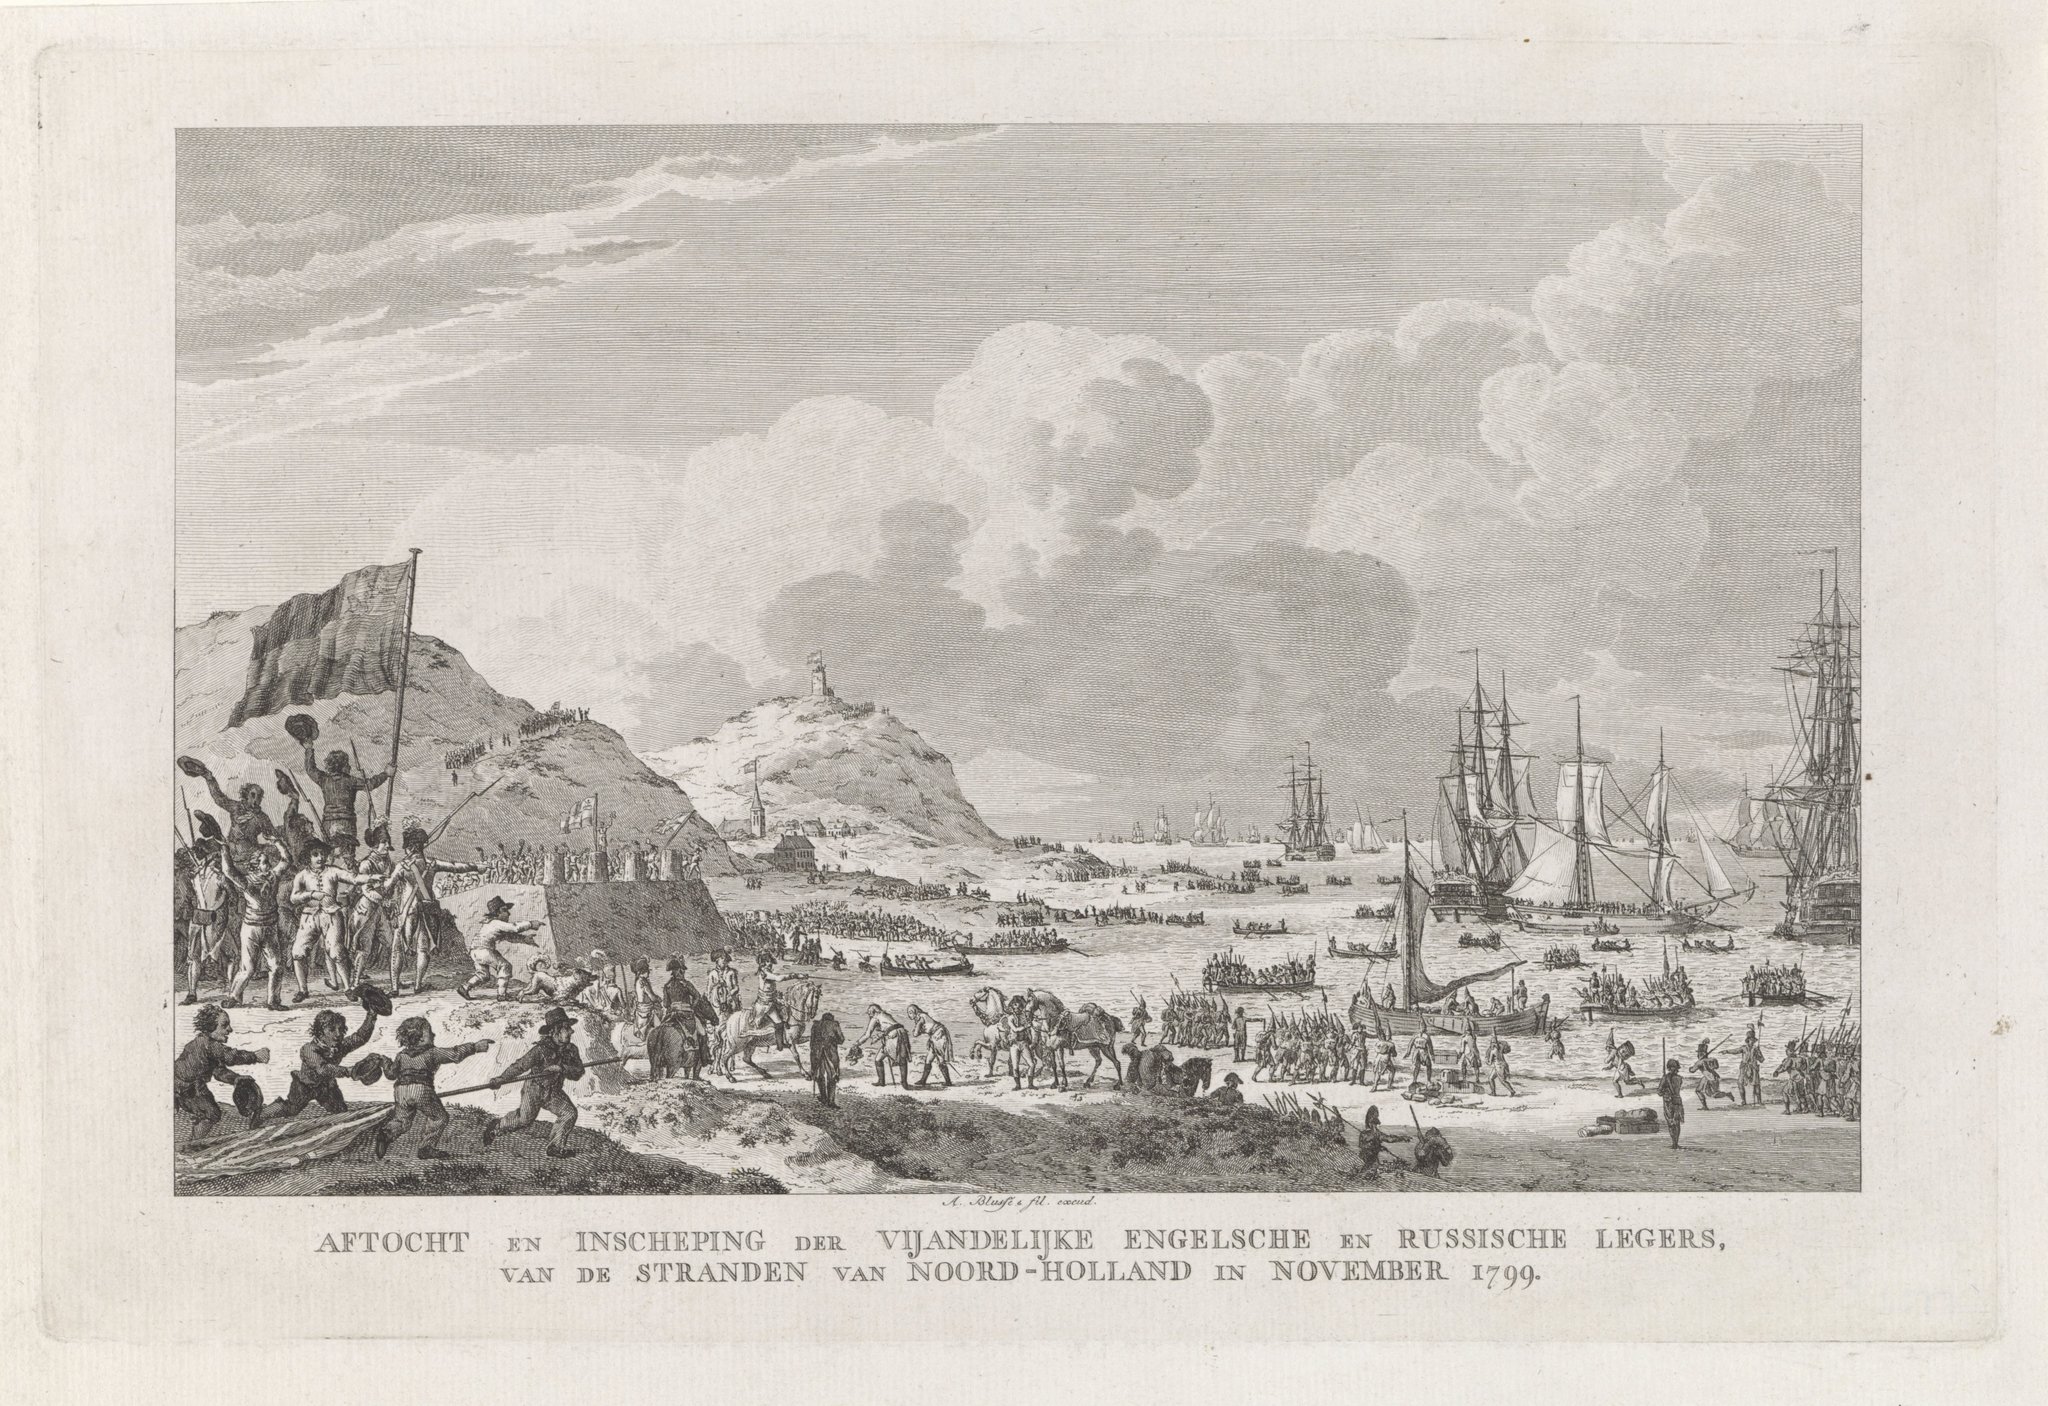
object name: print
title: Aftocht van de Britten en Russen, 1799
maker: Anonymous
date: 1799-1800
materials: paper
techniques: engraving, etching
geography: dordrecht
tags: transport, train (military) (+ sailing-ships), den helder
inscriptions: collector's mark: Lugt 2228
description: Het vertrek van de Britse en Russische troepen vanaf het strand bij Den Helder in sloepen naar gereedliggende schepen, 29 november 1799. Terwijl de commandanten elkaar groeten wordt de Bataafse vlag gehezen en slepen jongetjes de Britse vlag over de grond. Zie ook de pendant.